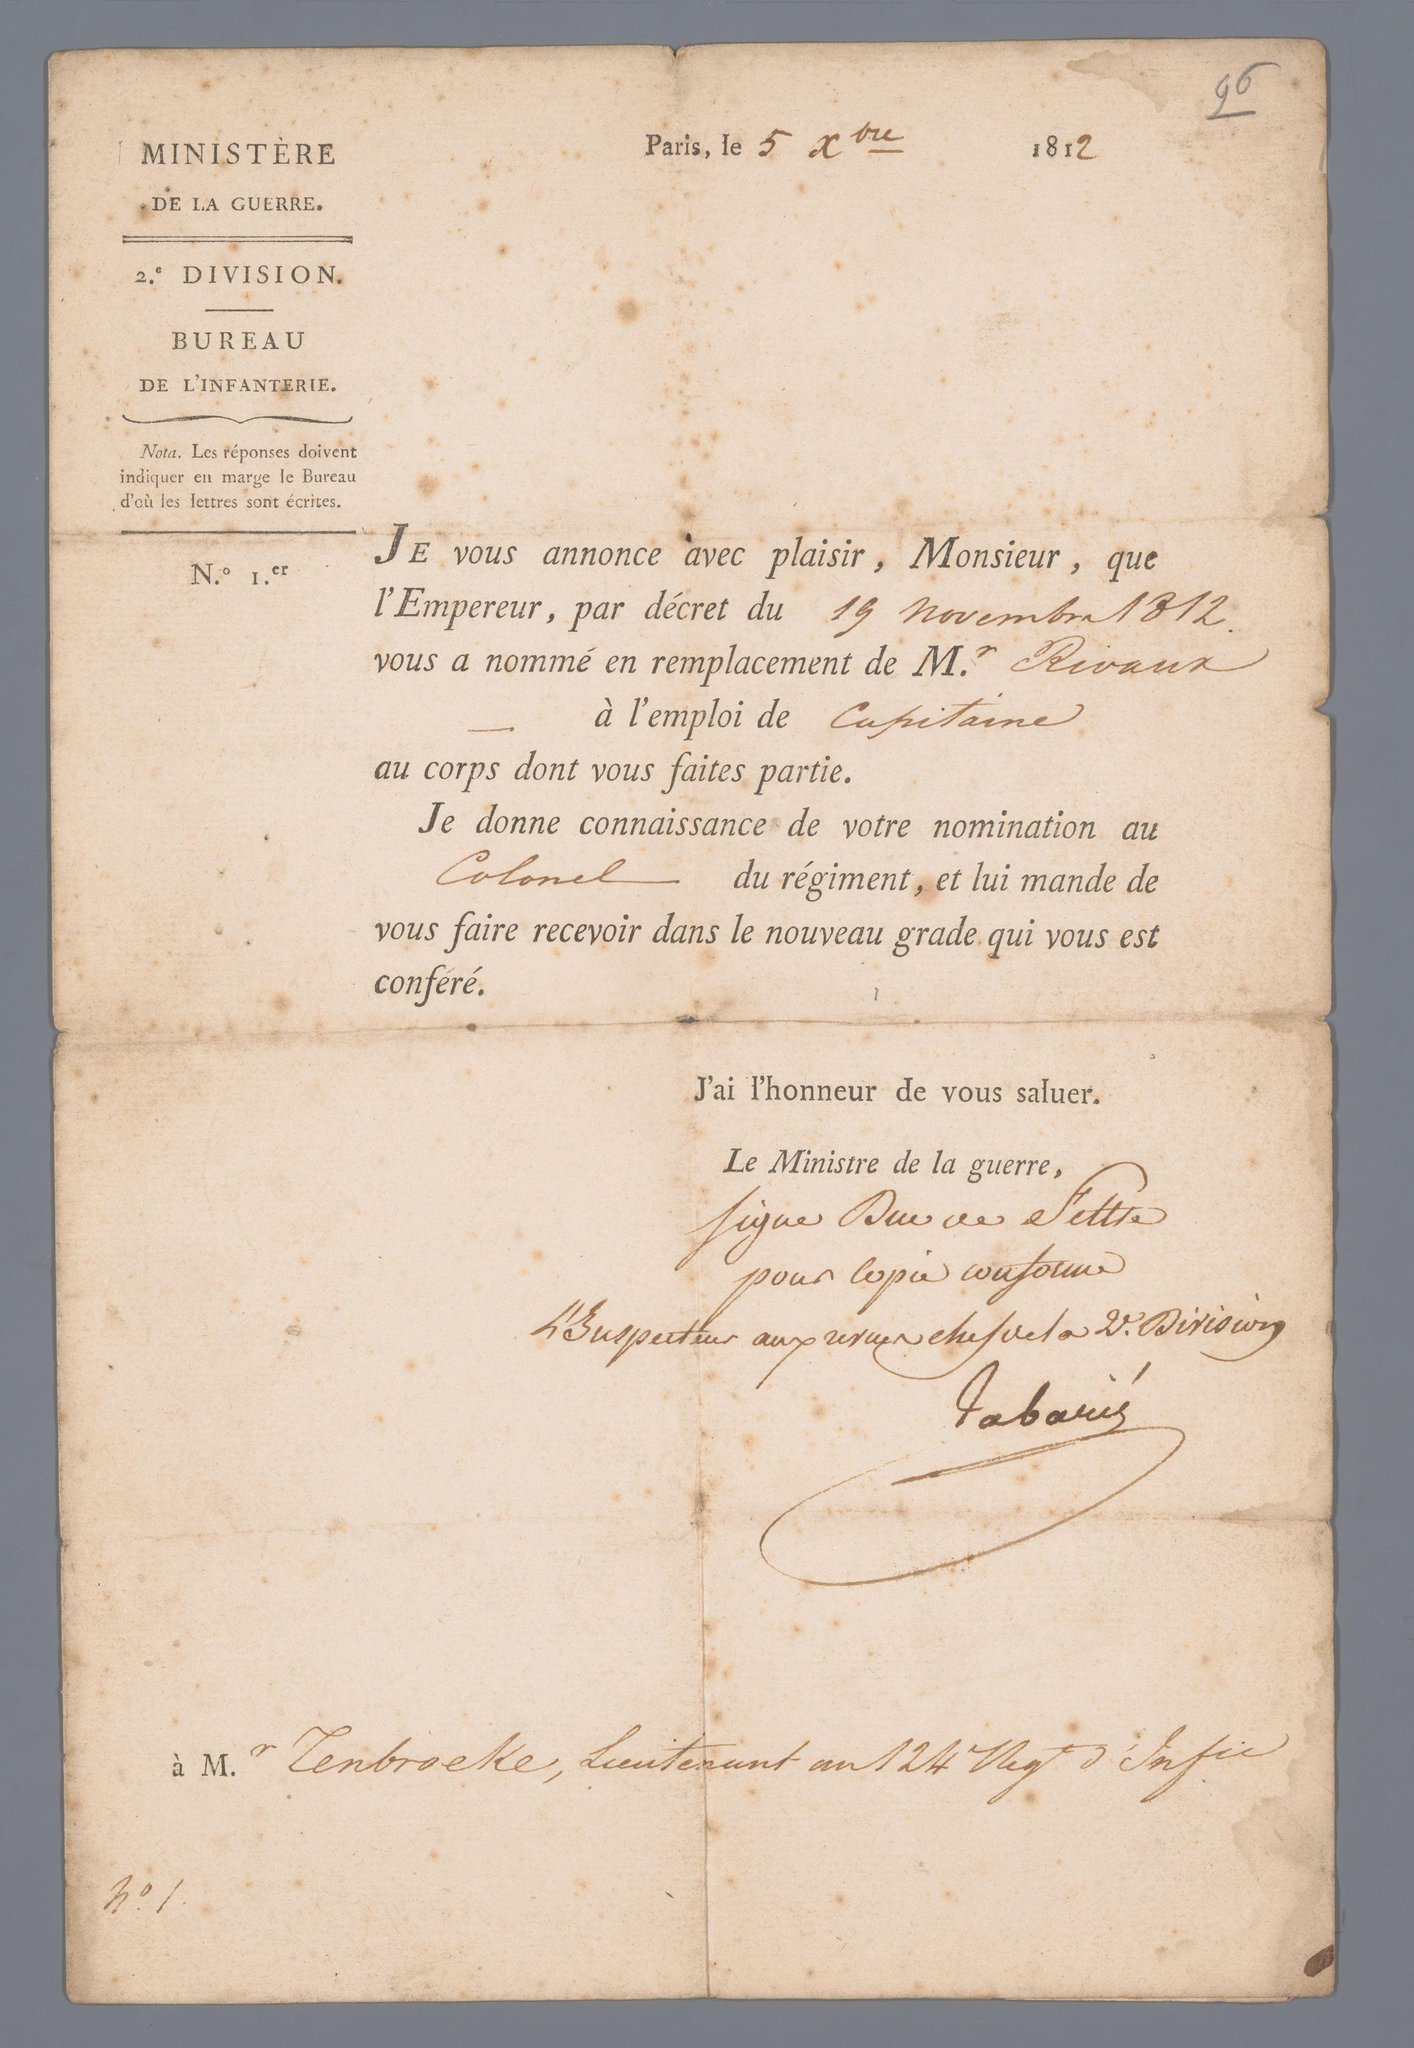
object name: document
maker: Anonymous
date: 1812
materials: ink, paper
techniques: printing, writing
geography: paris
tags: kapitein, broeke, ten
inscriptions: date